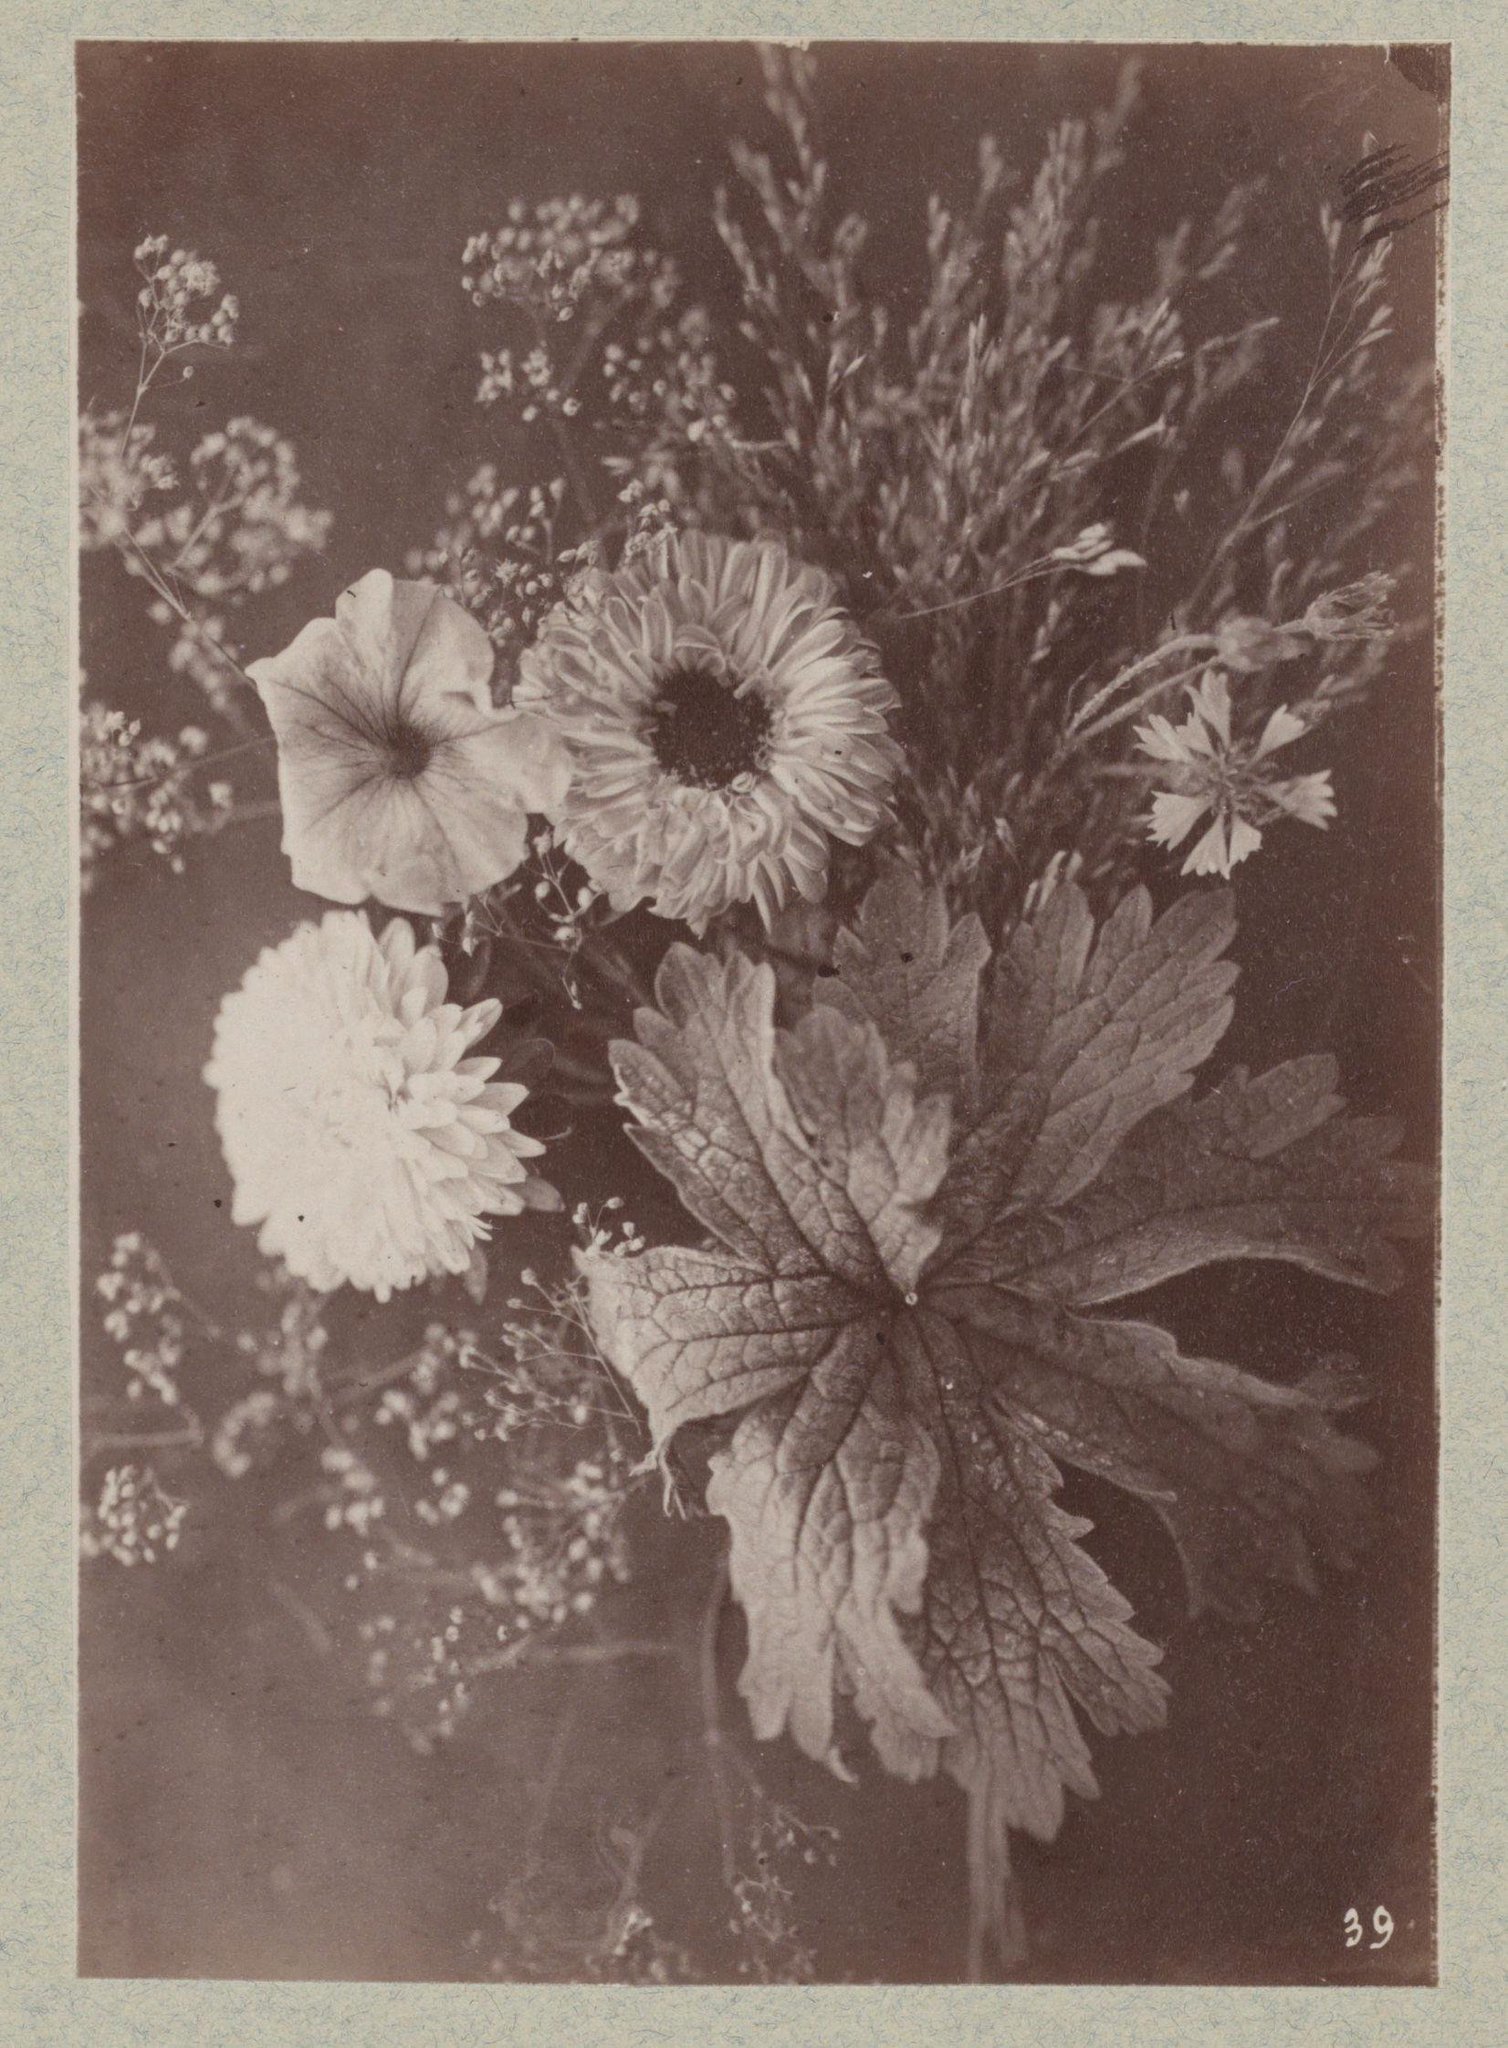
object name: photograph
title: Bloemstudie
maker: a. calavas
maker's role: publisher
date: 1875-1895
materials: cardboard, photographic support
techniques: albumen print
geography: paris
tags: flowers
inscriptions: number: ‘39’, collector's mark: Lugt 3937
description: Onderdeel van Verzamelband met foto's van bloemstudies.